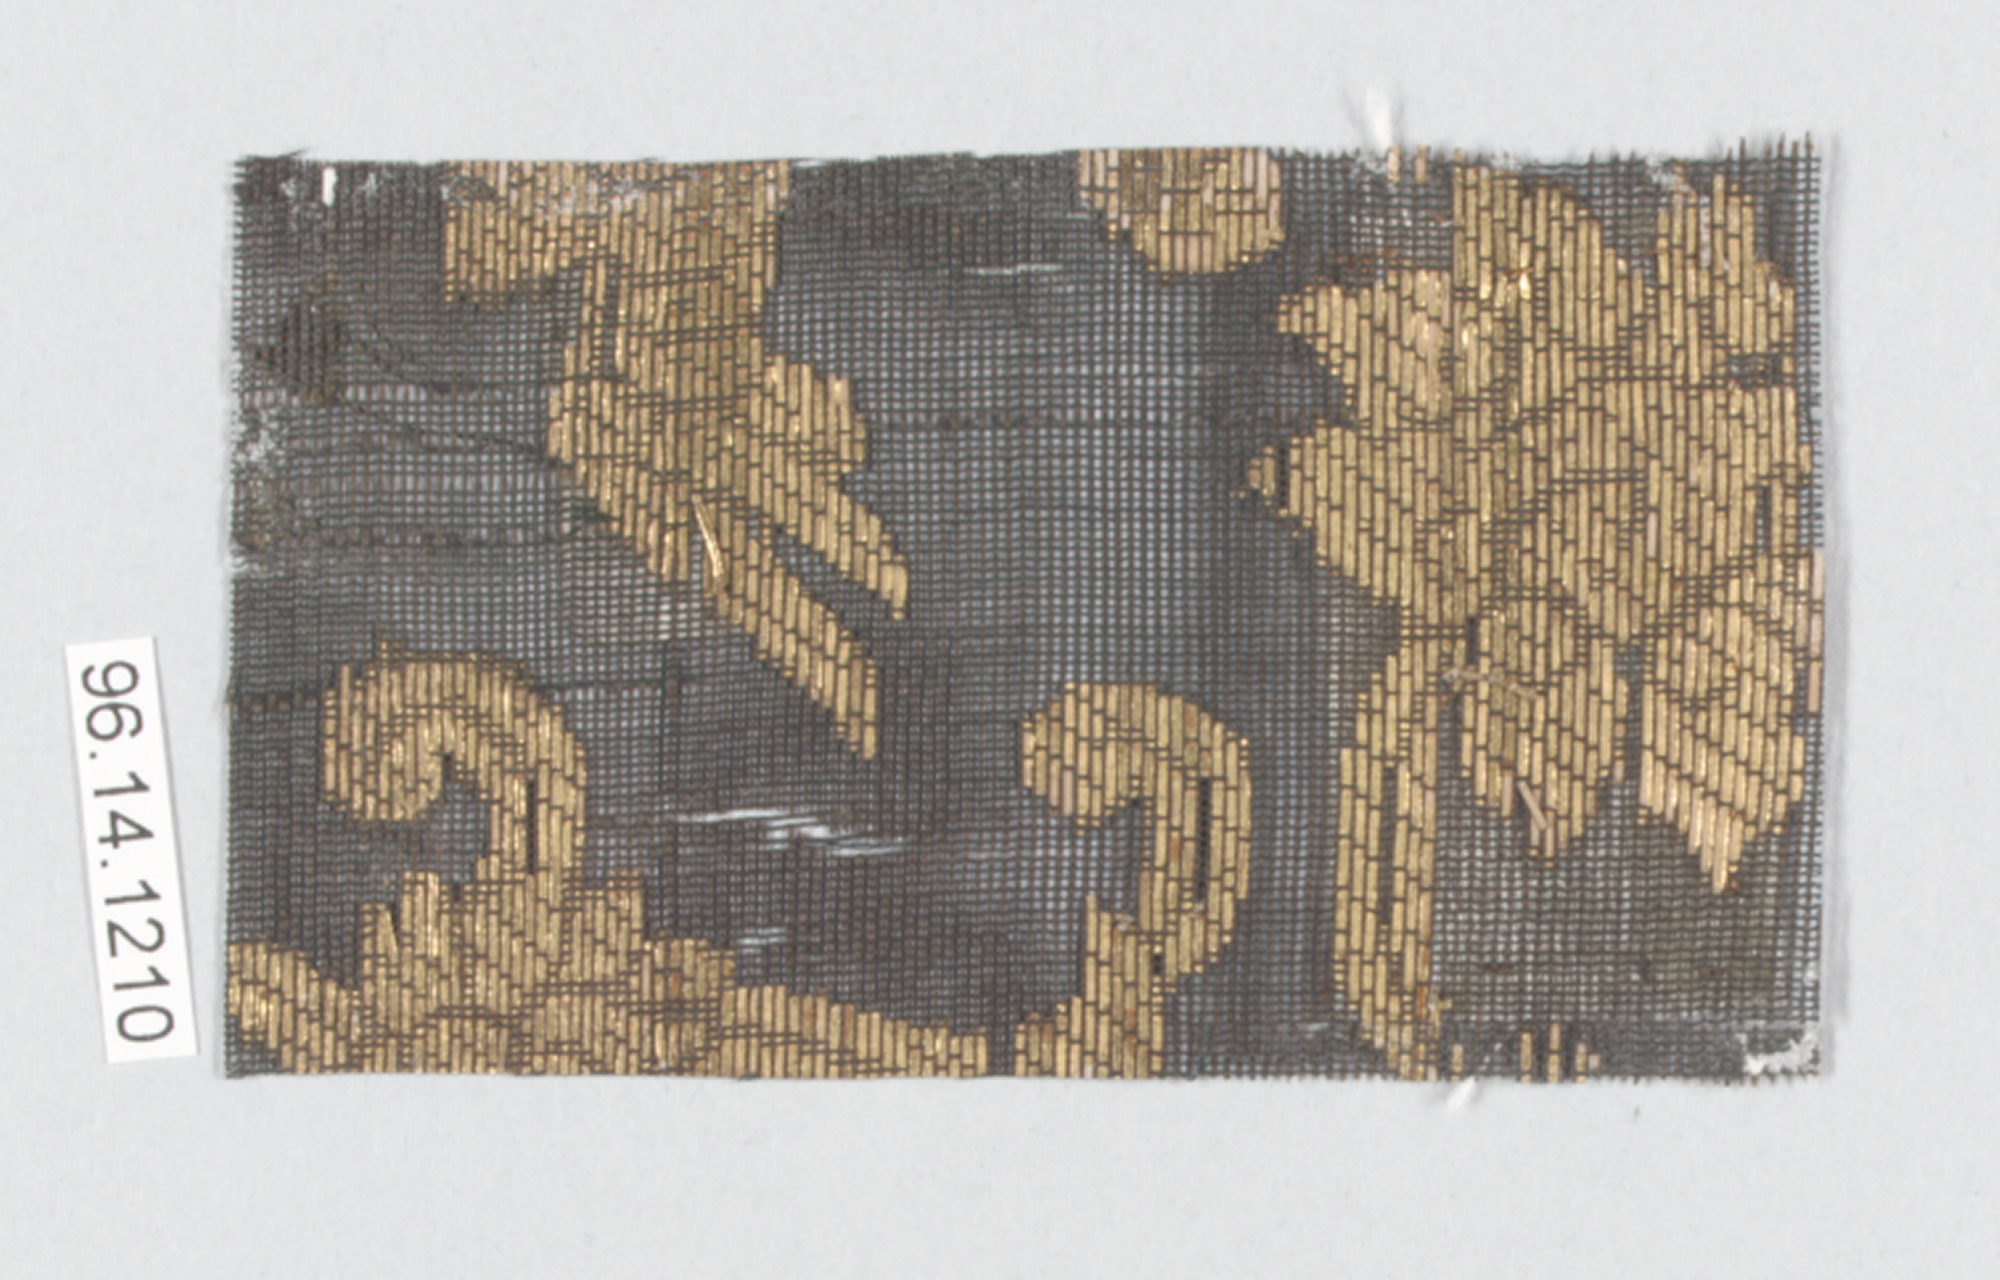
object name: piece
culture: japanese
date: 1801-1900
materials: metal thread, silk